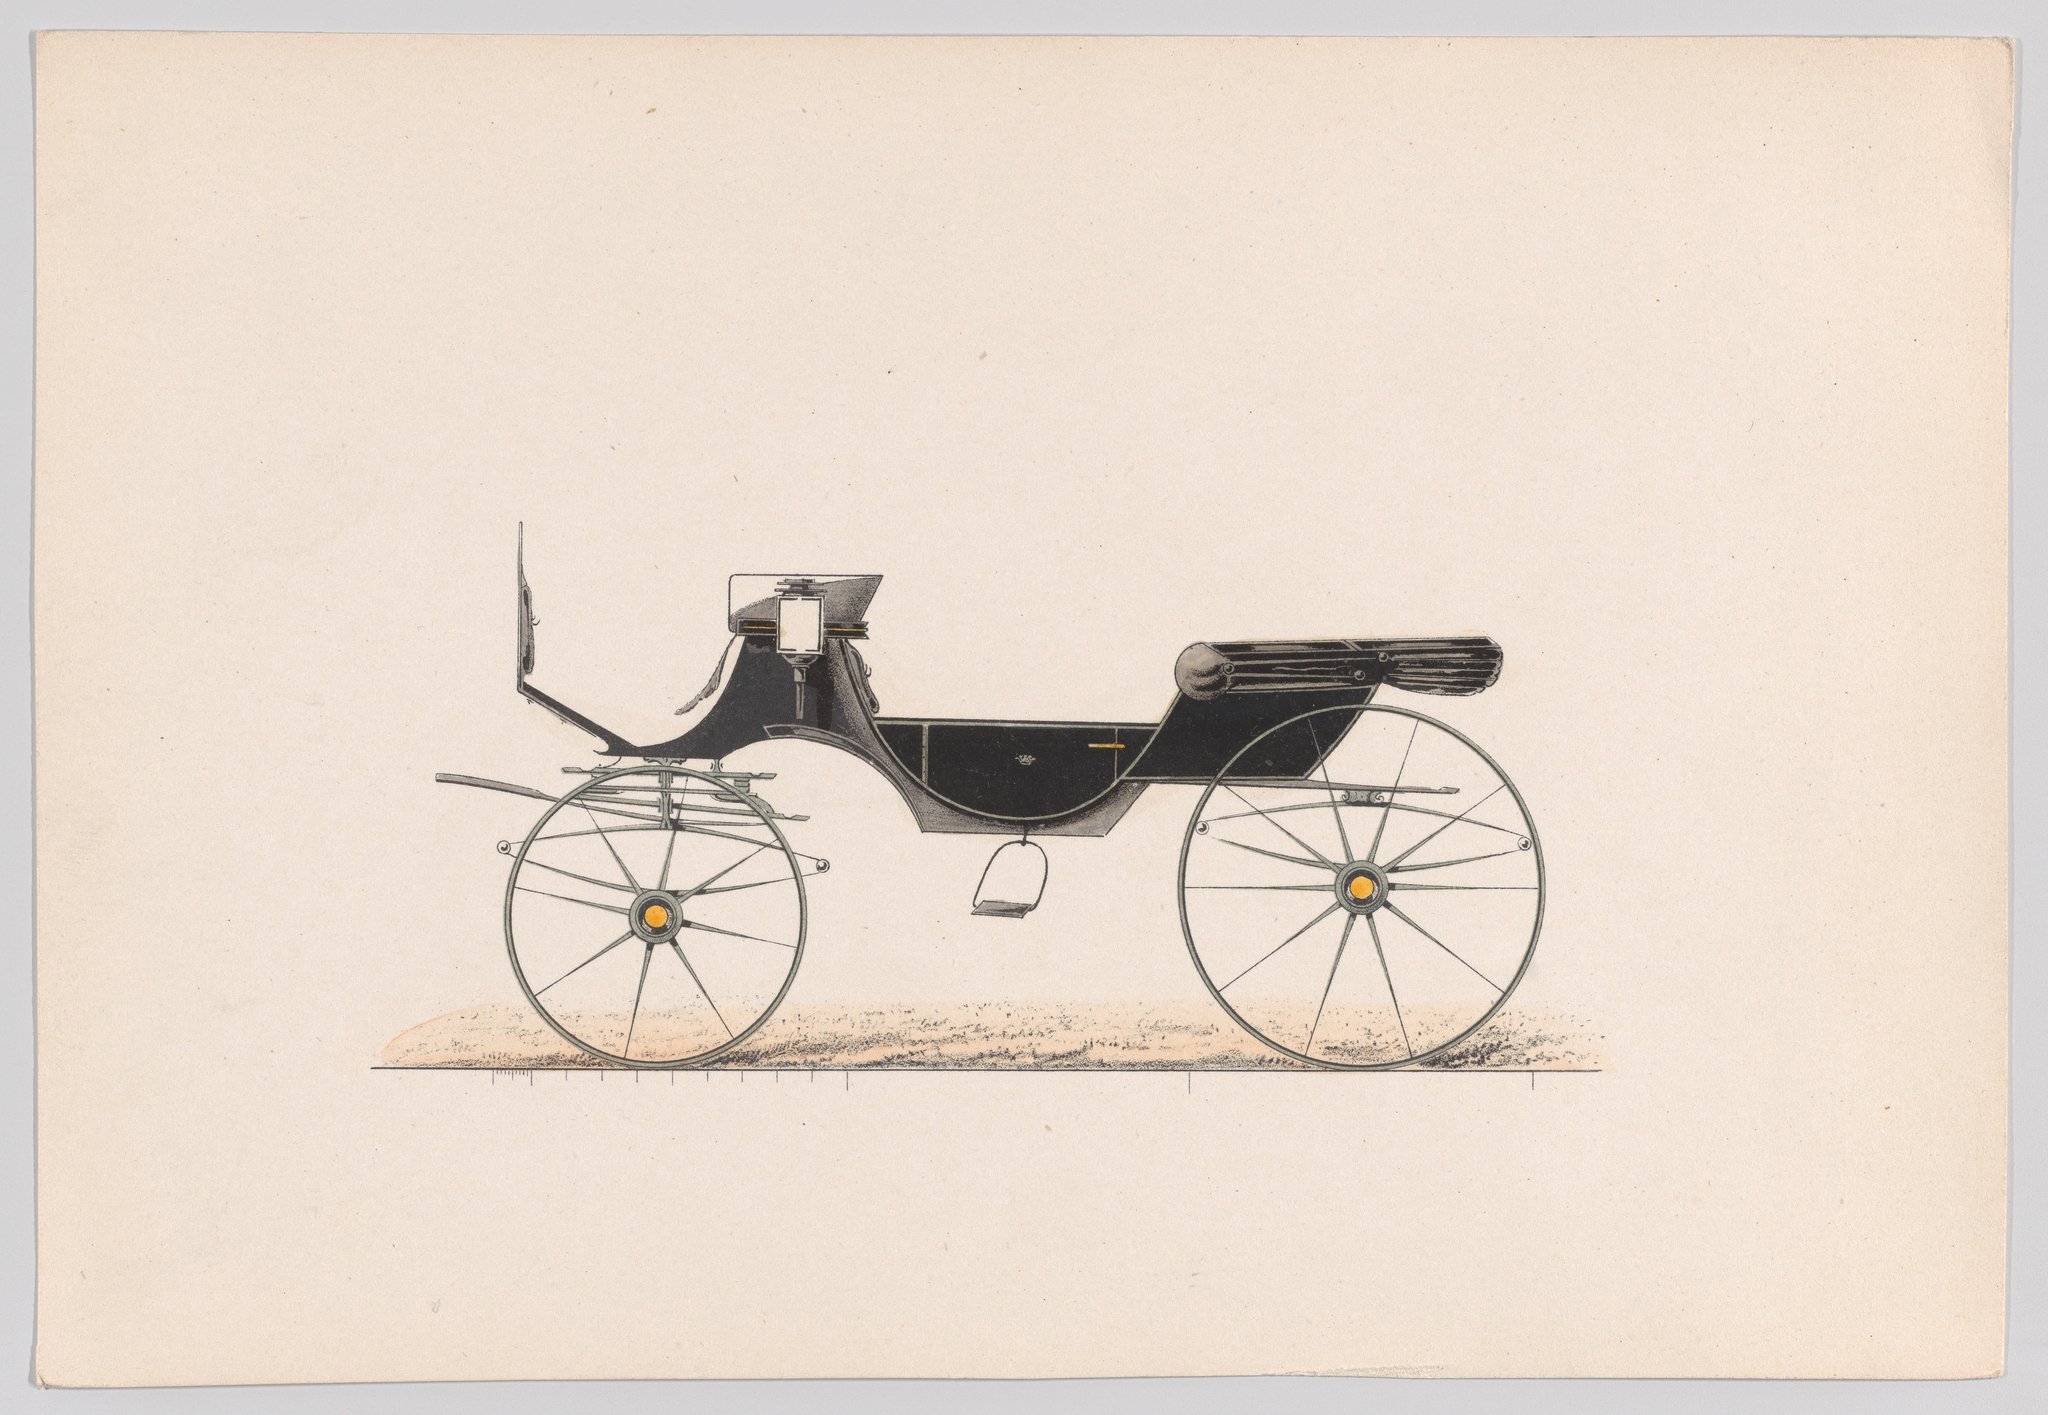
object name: print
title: Design for Vis-A-Vis Cabriolet Carriage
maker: anonymous, french, 19th century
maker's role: artist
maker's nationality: french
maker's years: 1800-1900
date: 1870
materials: gum arabic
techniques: hand coloring, lithograph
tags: carriages